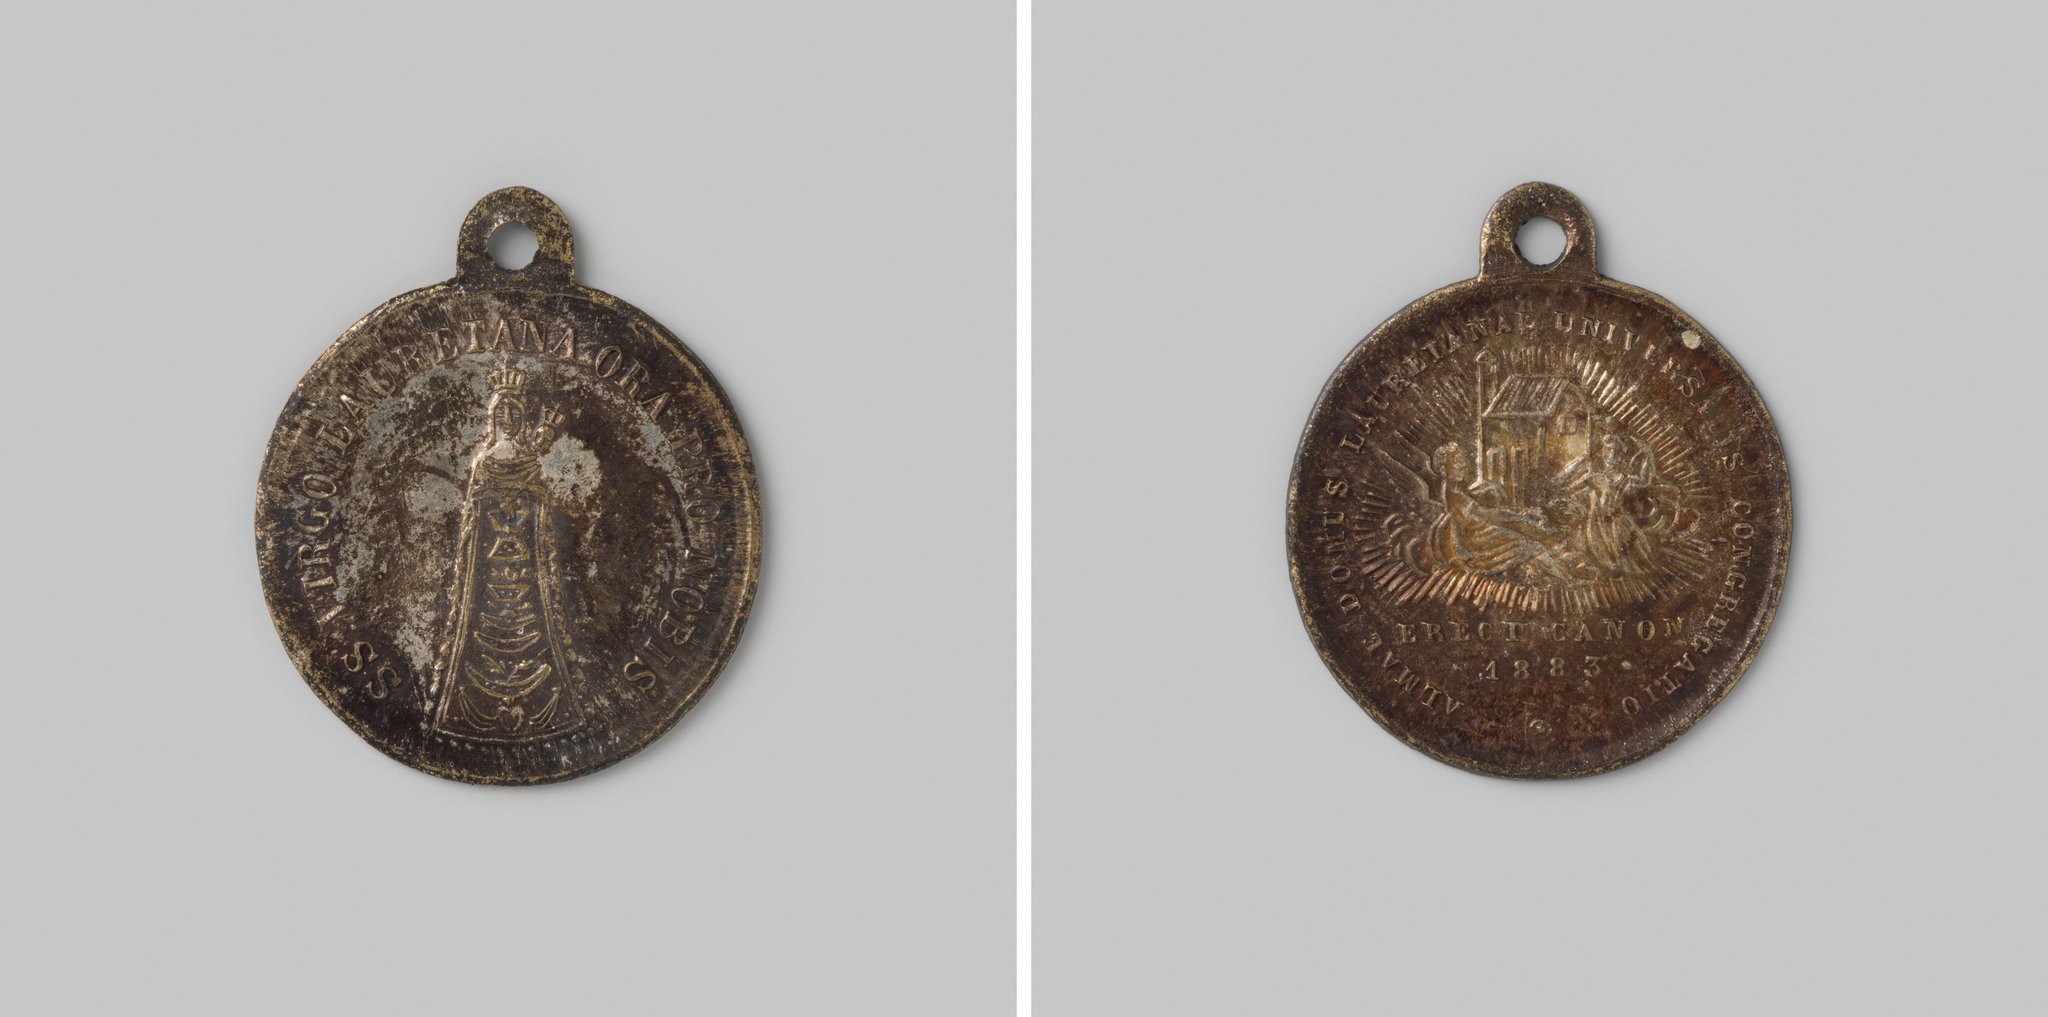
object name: history medal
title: Religieus draagteken met Maria van Loreto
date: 1750-1850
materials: silver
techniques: striking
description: Zilveren penning met draagoog, op de voorzijde Maria van Loreto met omschrift, op de keerzijde twee engelen voor het Heilige Huis van Loreto, met afsnedetekst en omschrift.